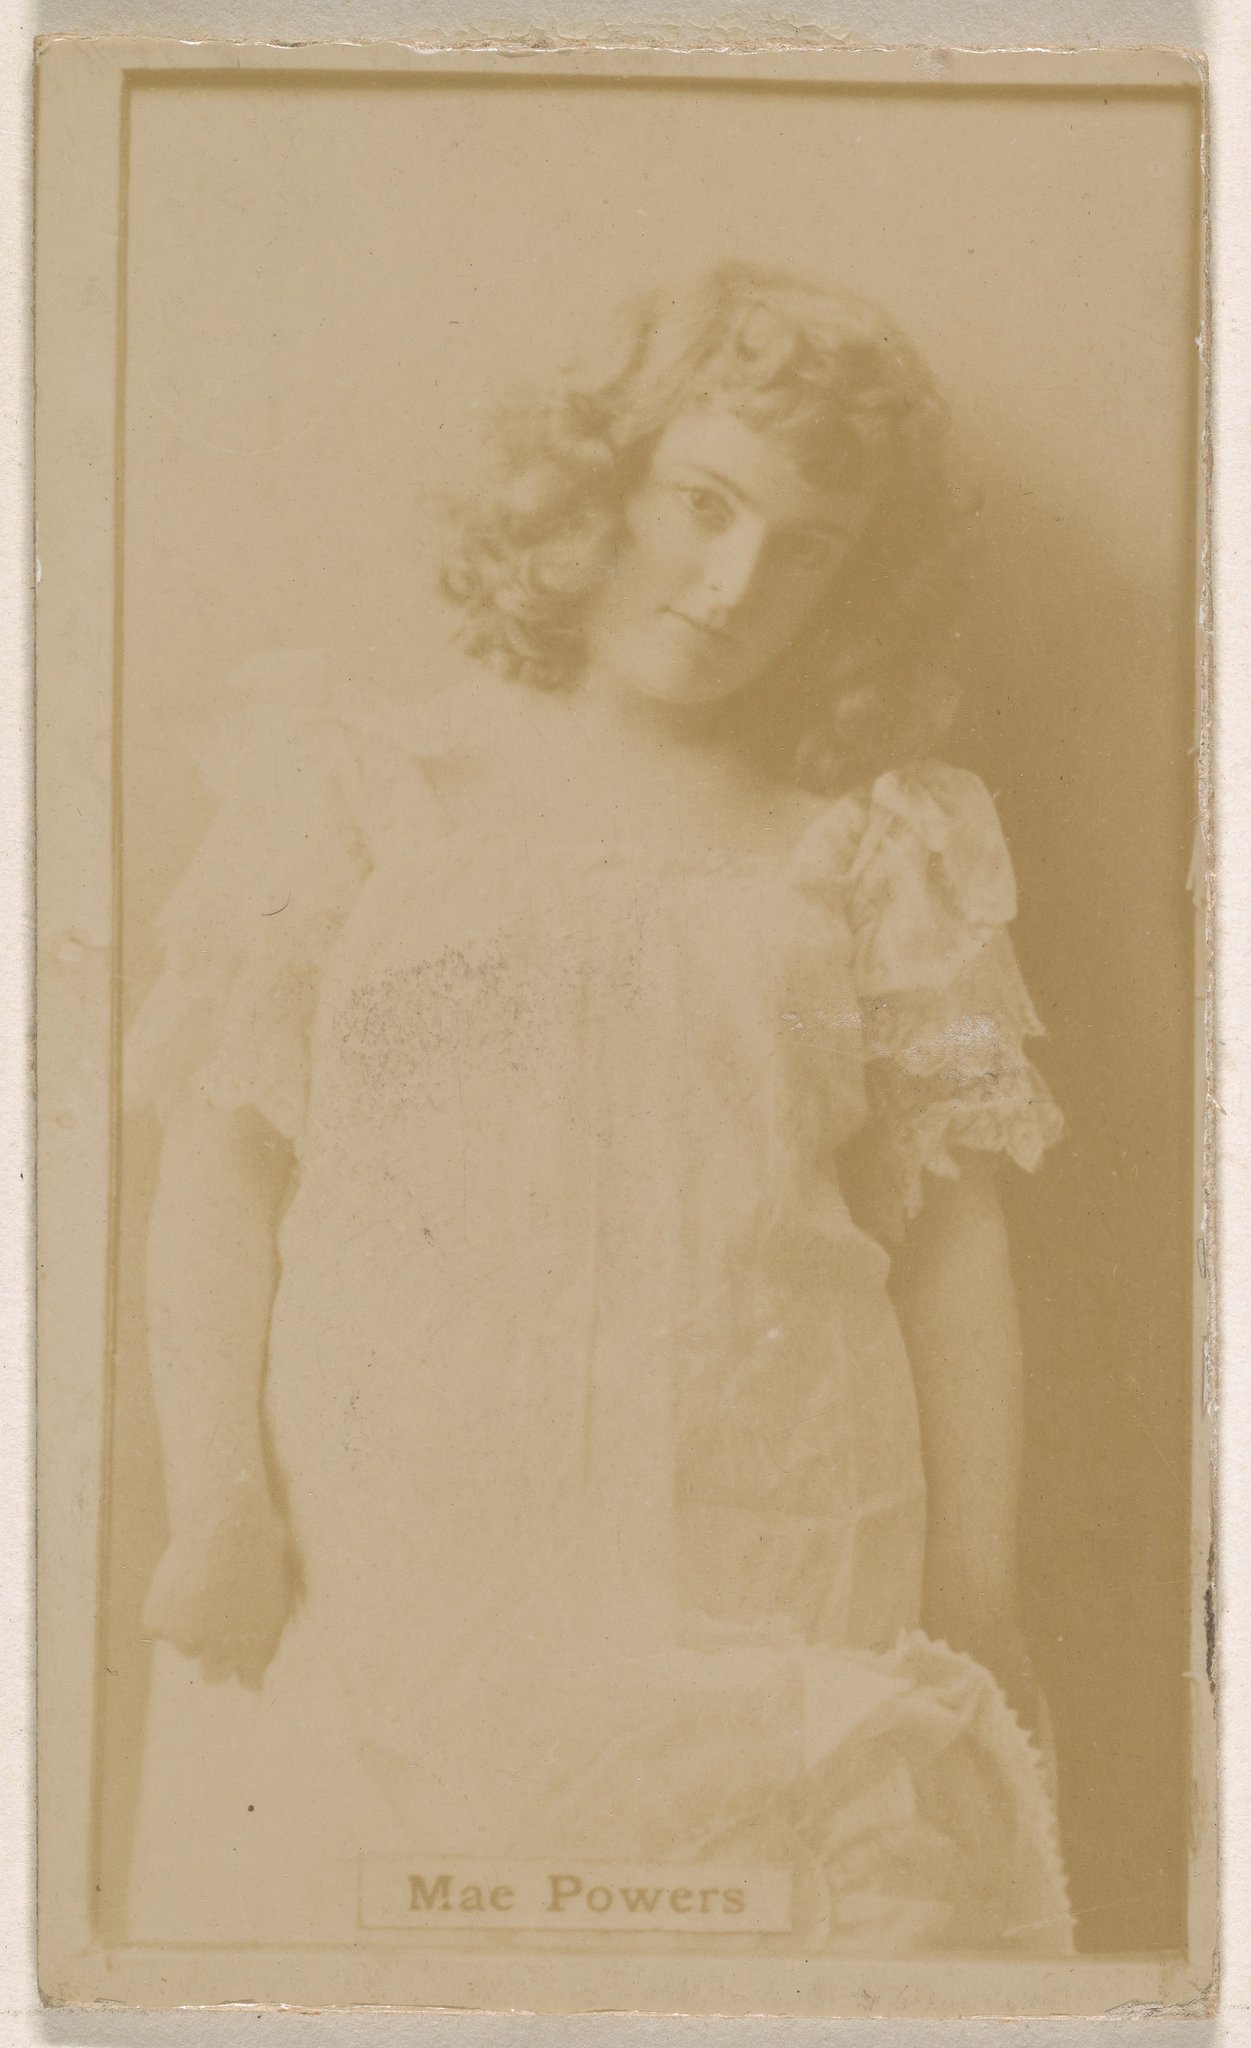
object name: photograph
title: Mae Powers, from the Actresses series (N245) issued by Kinney Brothers to promote Sweet Caporal Cigarettes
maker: kinney brothers tobacco company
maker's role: publisher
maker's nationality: american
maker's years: 1869-2011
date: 1890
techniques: albumen silver print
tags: portraits,women,actresses